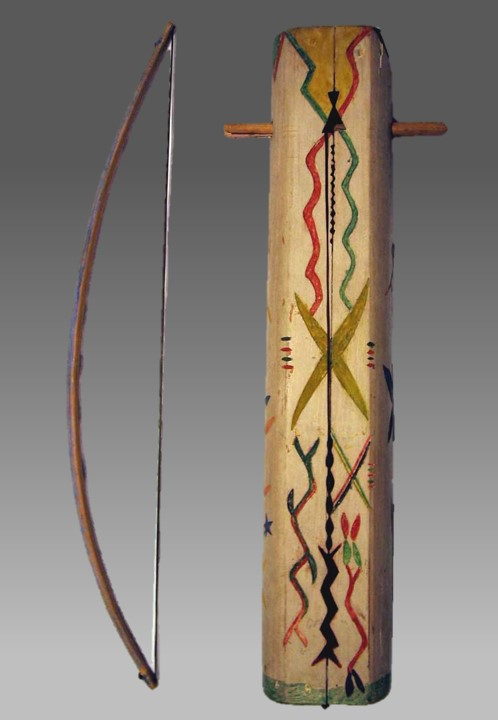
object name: tsii' edo' ai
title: Tsii' Edo' Ai (Apache Fiddle)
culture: native american, apache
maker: lawrence gotelay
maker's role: maker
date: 1887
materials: hair, wood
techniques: polychrome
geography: united states